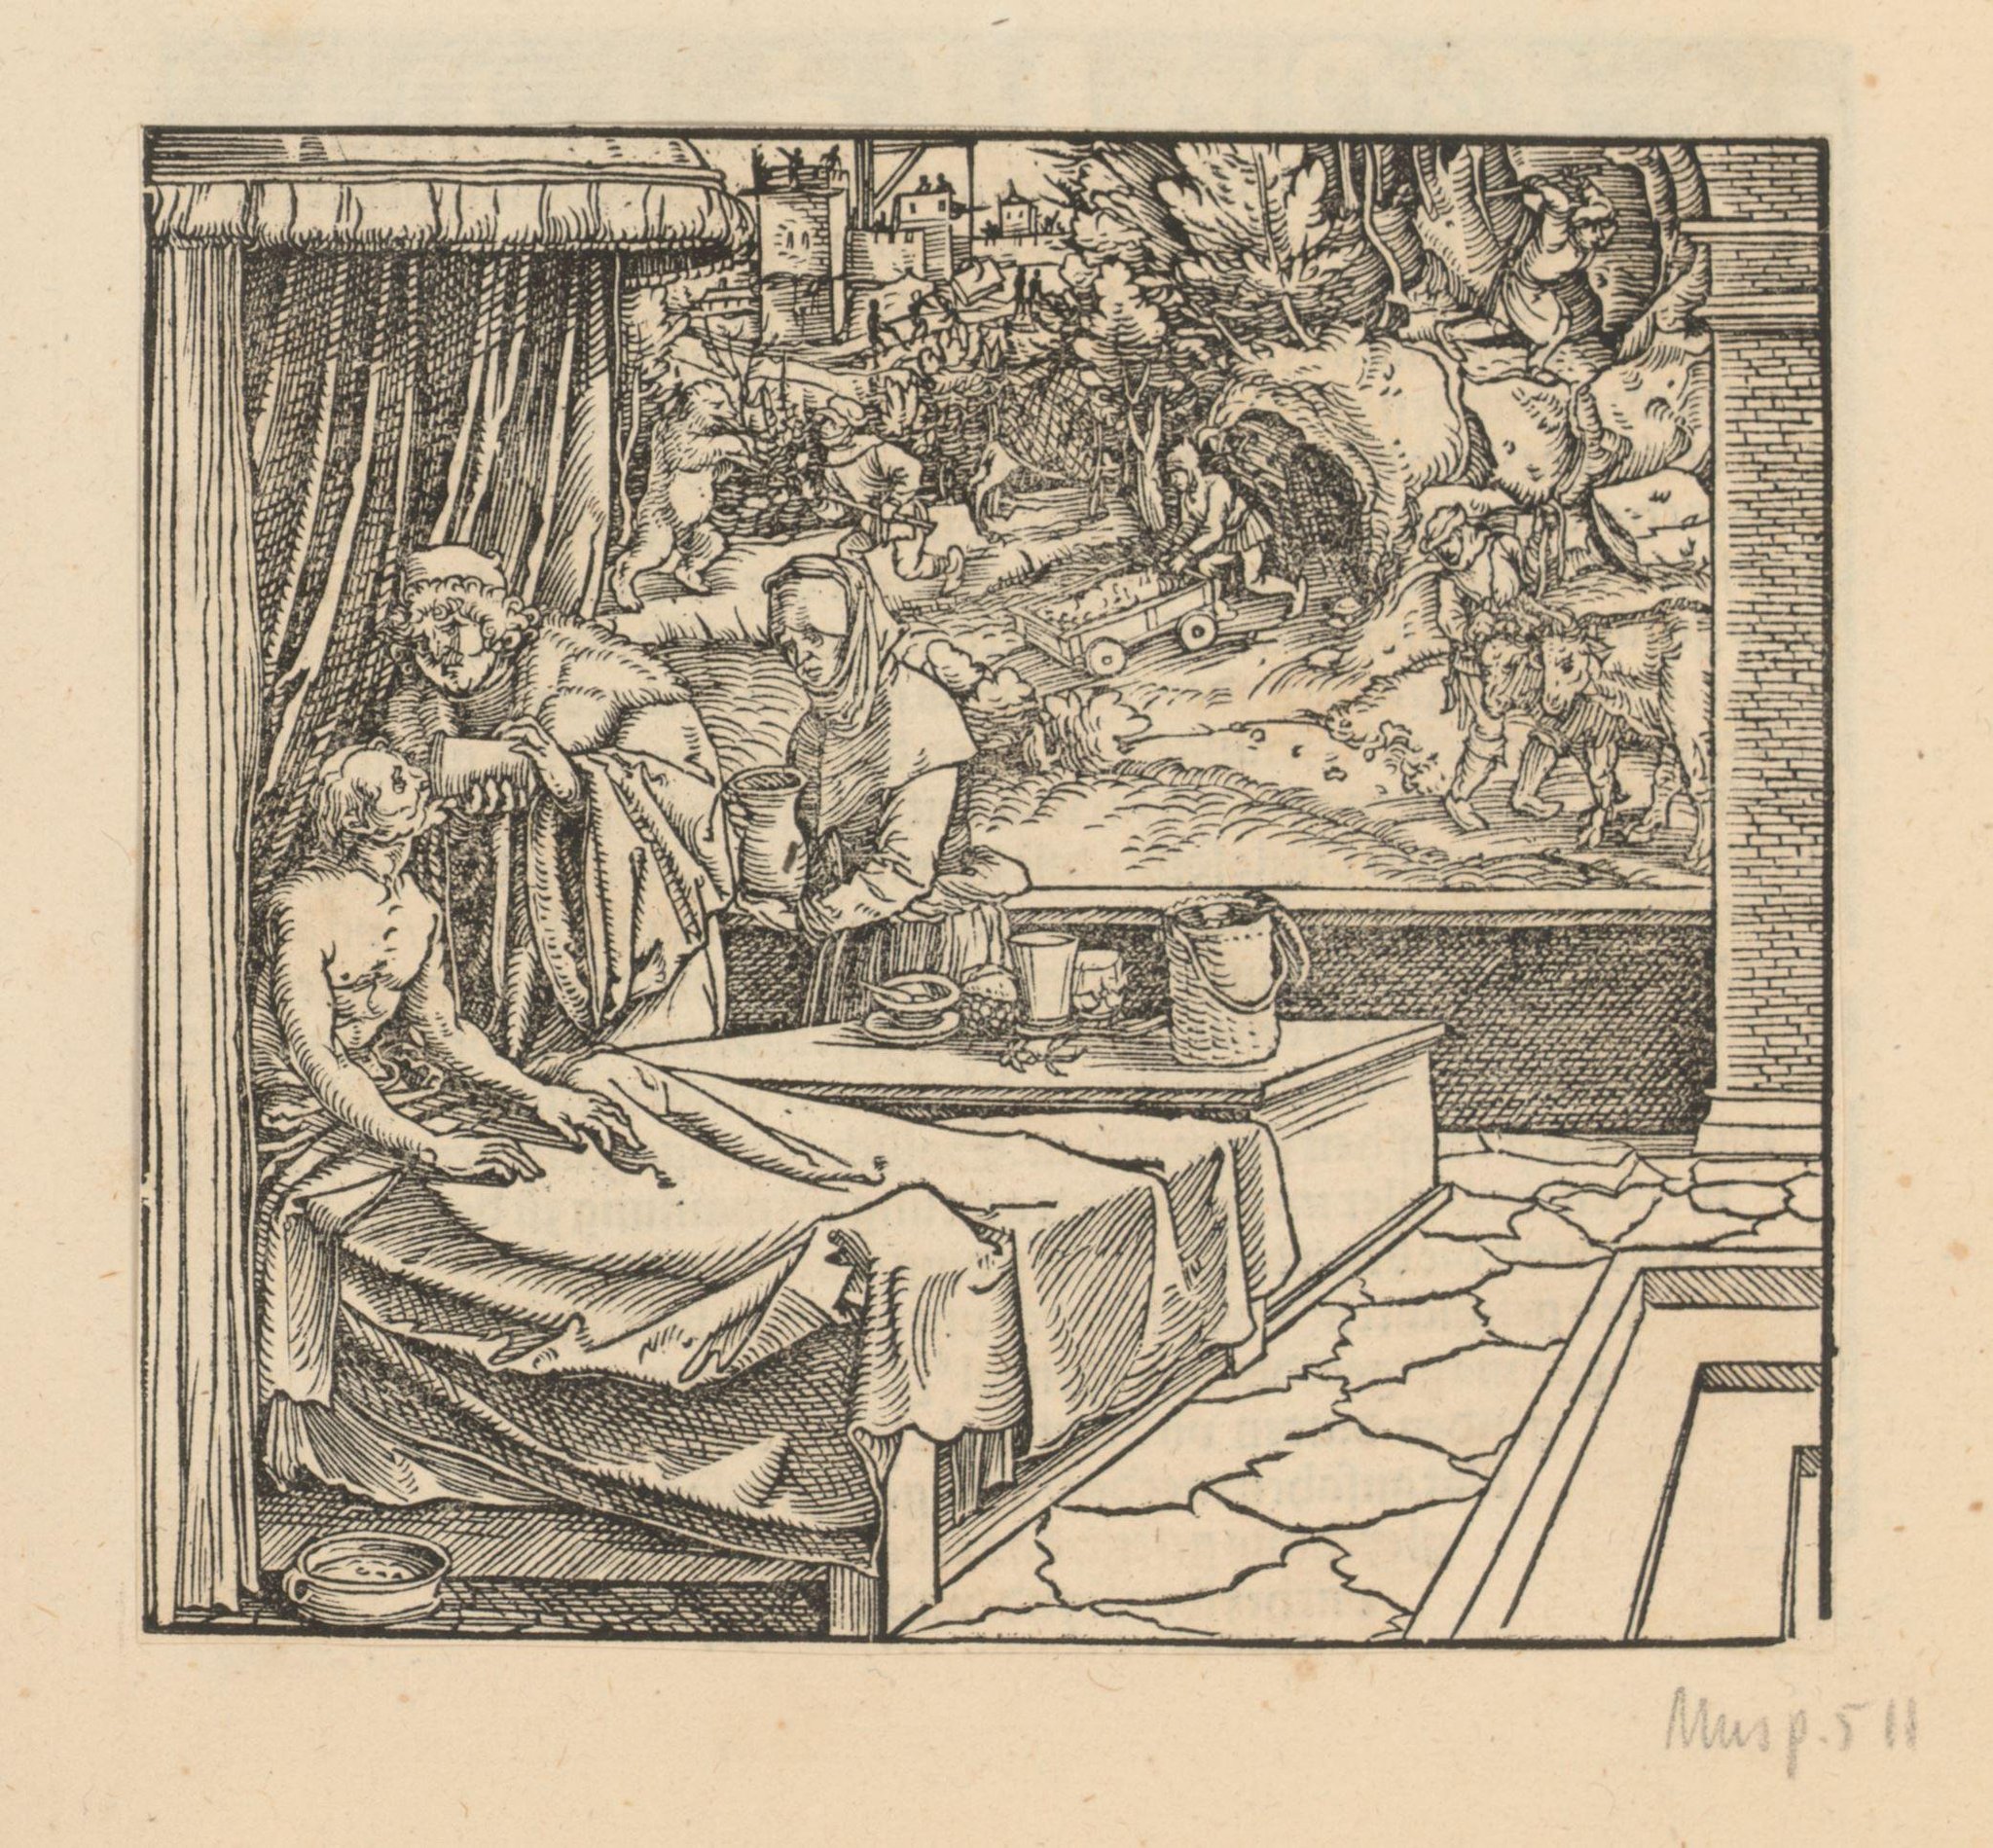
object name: album leaf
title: Zieke man in bed wordt verzorgd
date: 1514-1531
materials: paper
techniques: letterpress printing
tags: patient, sick person, nursing, tending the sick, labour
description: Deze prent is gebruikt in: Cicero, Marcus Tulius. Officia M.T.C. Ein Buch so Marcus Tullius Cicero der Römer zu seynem (...). [Vertaald uit het Latijn door] Johann von Schwarzenberg. Augsburg: Heinrich Steiner, 1531.